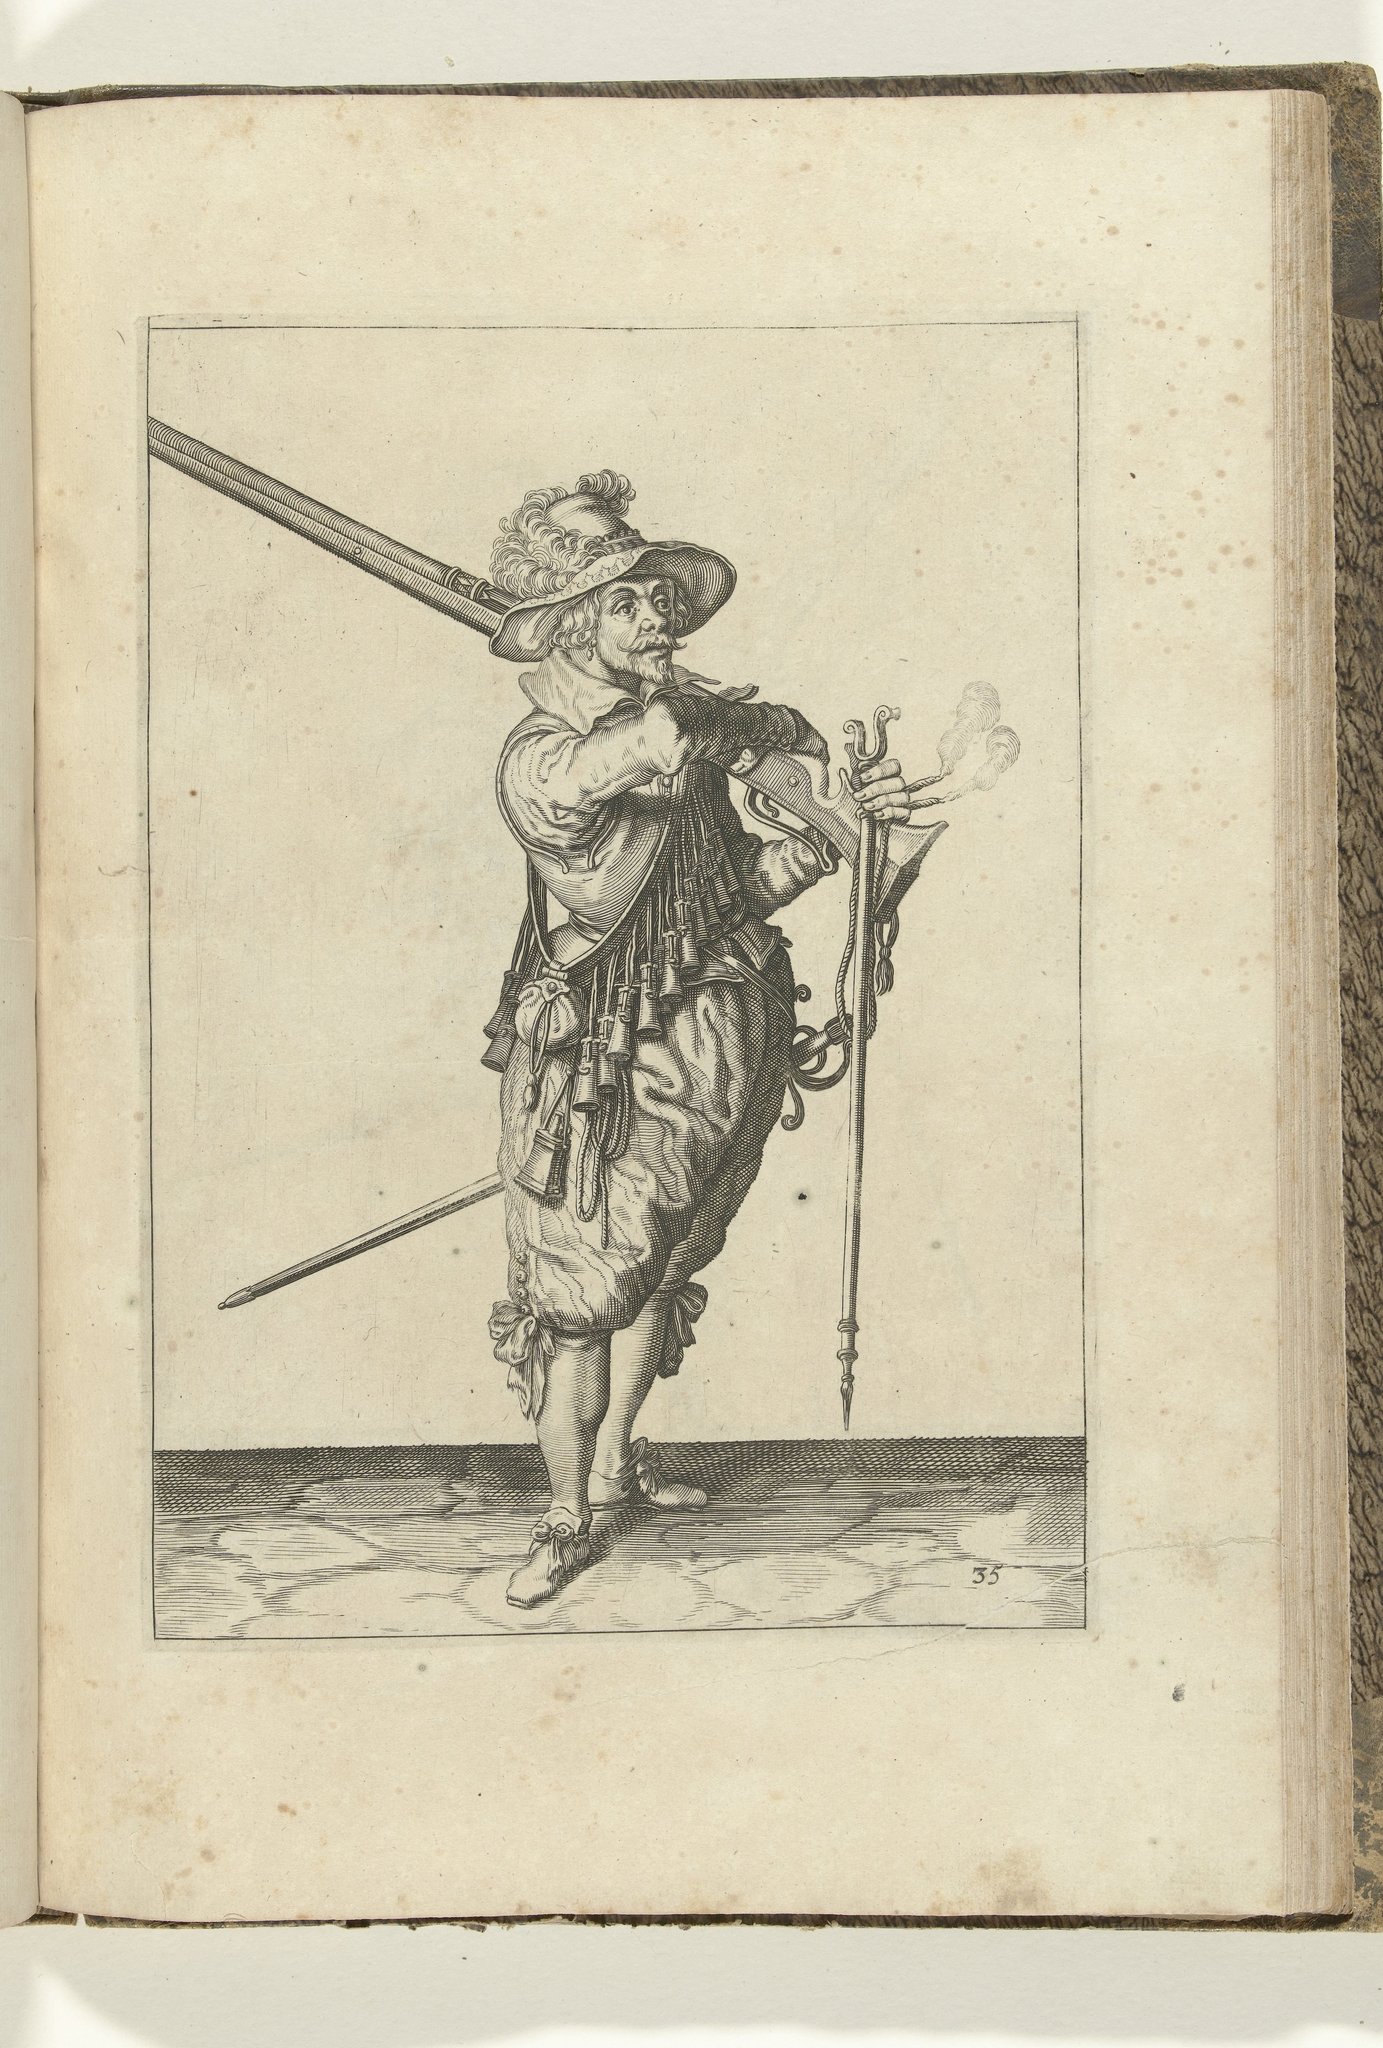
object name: print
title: Soldaat op wacht die zijn musket van zijn schouder neemt (nr. 35), ca. 1600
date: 1597-1608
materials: paper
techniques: engraving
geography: amsterdam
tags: the hague, maurice (prince of orange), handling of weapons ~ military training, weapons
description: Een soldaat op wacht, ten voeten uit, naar rechts, die een musket (een bepaald type vuurwapen) van zijn linkerschouder neemt met zijn rechterhand (nr. 35), ca. 1600. In zijn linkerhand behalve de kolf van het musket ook een furket (musketvork) en een brandende lont. Het gaat dus om dezelfde positie als degene die op de derde prent van de serie getoond wordt. Plaat 35 in de instructies voor het hanteren van het musket: Brief enseignement, sur les pourtraitz figurez, touchant le droit maniement du Mousquet. Onderdeel van de illustraties in een Franse editie van J. de Gheyns Wapenhandelinghe: J. de Gheyn, Maniement d'armes, d'arquebuses, mousquetz et piques : en conformité de l'ordre de Mour le Prince Maurice, Prince d'Orange, Amsterdam 1608. Krijgswezen rond 1600.